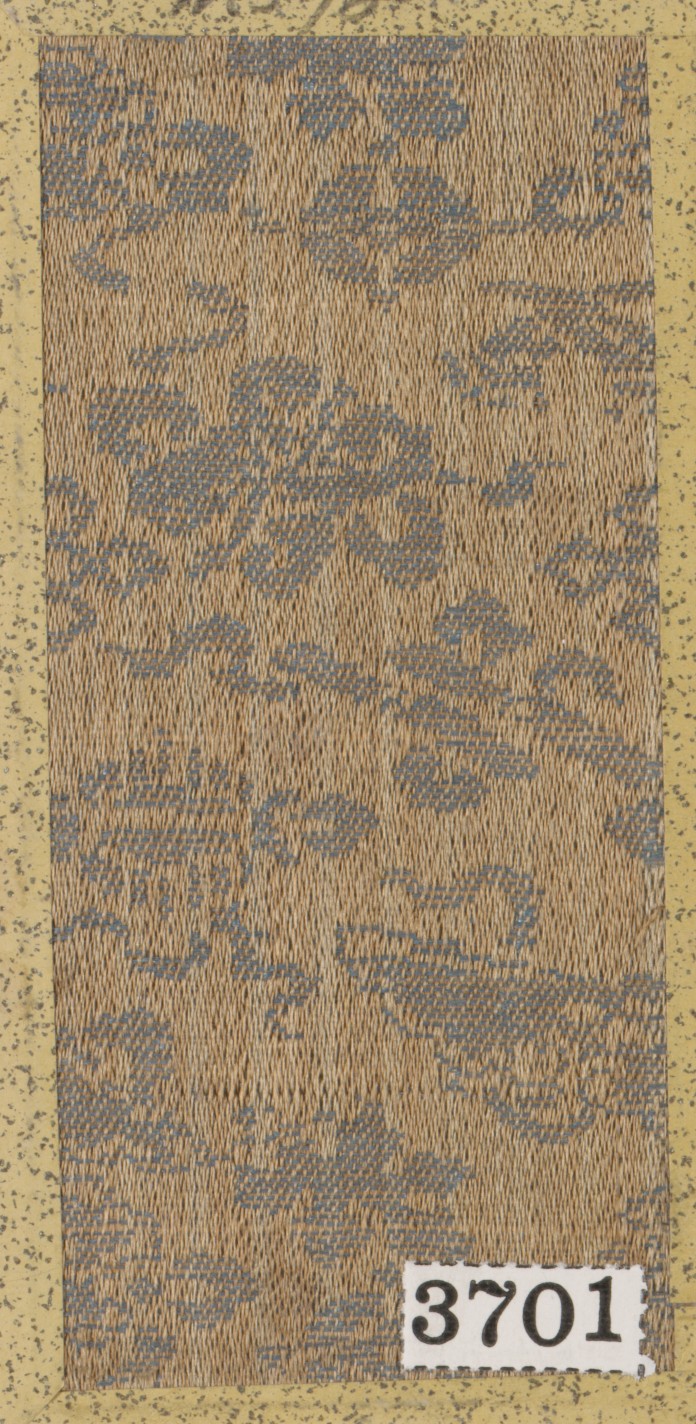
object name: sample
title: Textile Sample from Sample Book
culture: japanese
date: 1801-1900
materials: silk